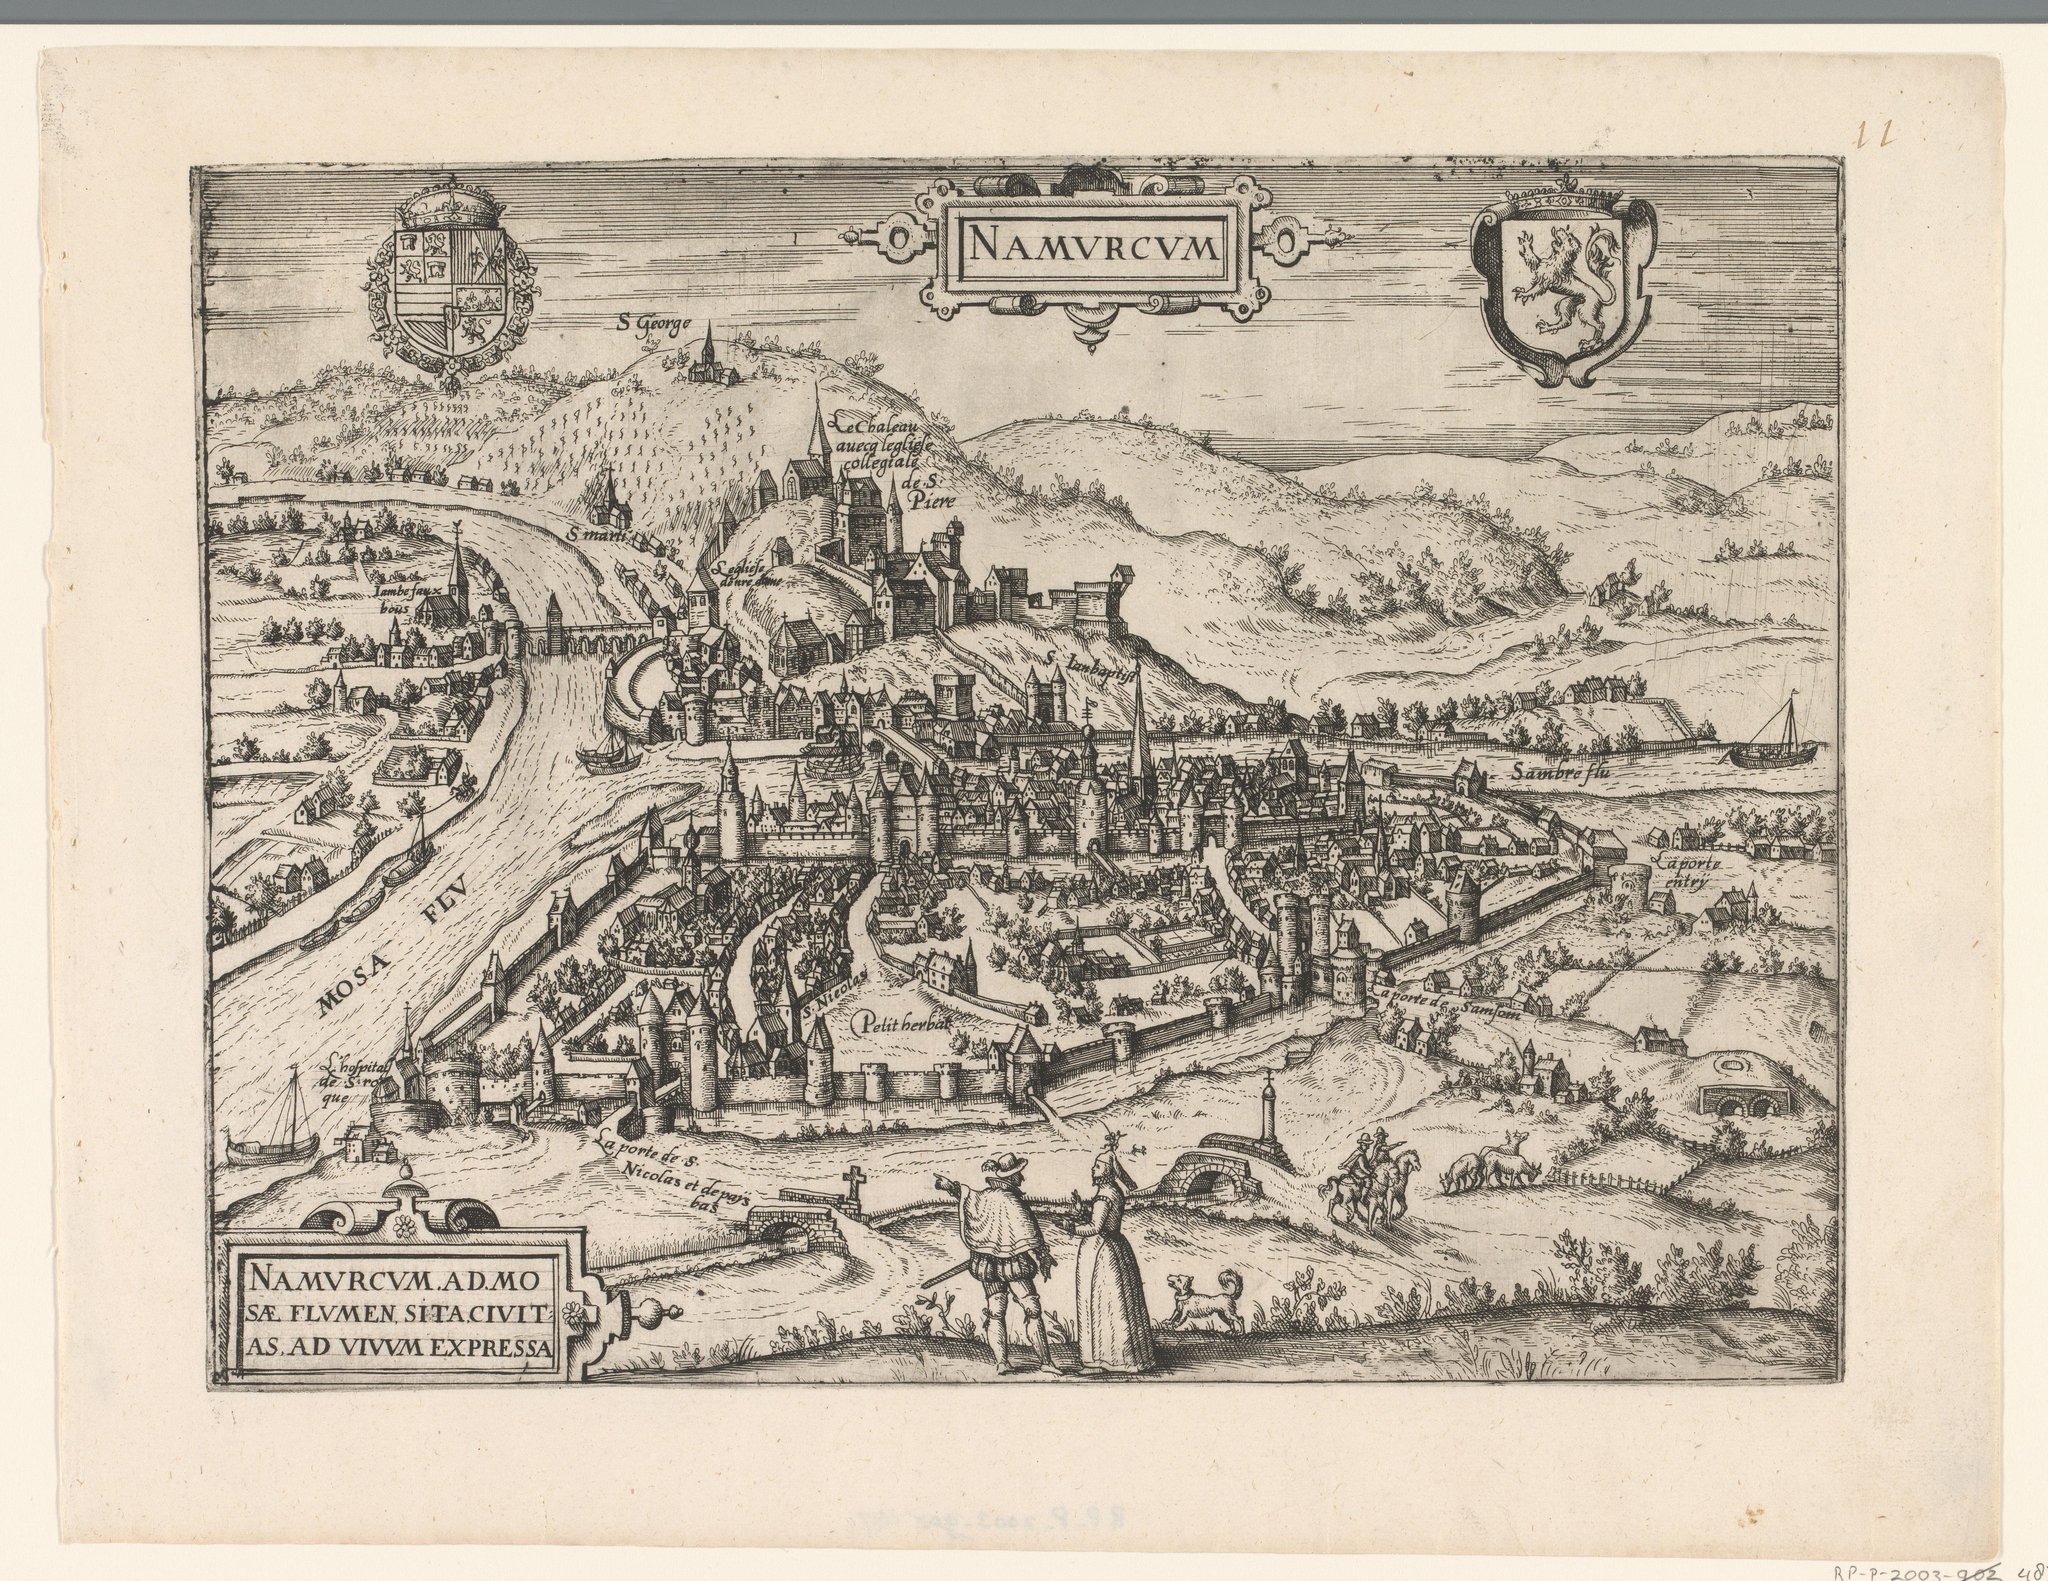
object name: print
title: Namurcum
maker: Anonymous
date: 1607-1609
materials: paper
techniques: etching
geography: southern netherlands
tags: prospect of city, town panorama, silhouette of city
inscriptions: number: ‘11’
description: Gezicht in vogelperspectief op de stad Namen (Namur). Midden boven een cartouche met de titel, linksboven het wapen van de koning van Spanje, rechtsboven een wapen met een klimmende leeuw. Linksonder een cartouche met een opschrift in het Latijn. Op de voorgrond een man en een vrouw met een hond. Onderdeel van de verzameling kaarten genomen uit een latere editie van: Descrittione di tutti i Paesi Bassi van Lodovico Guicciardini.